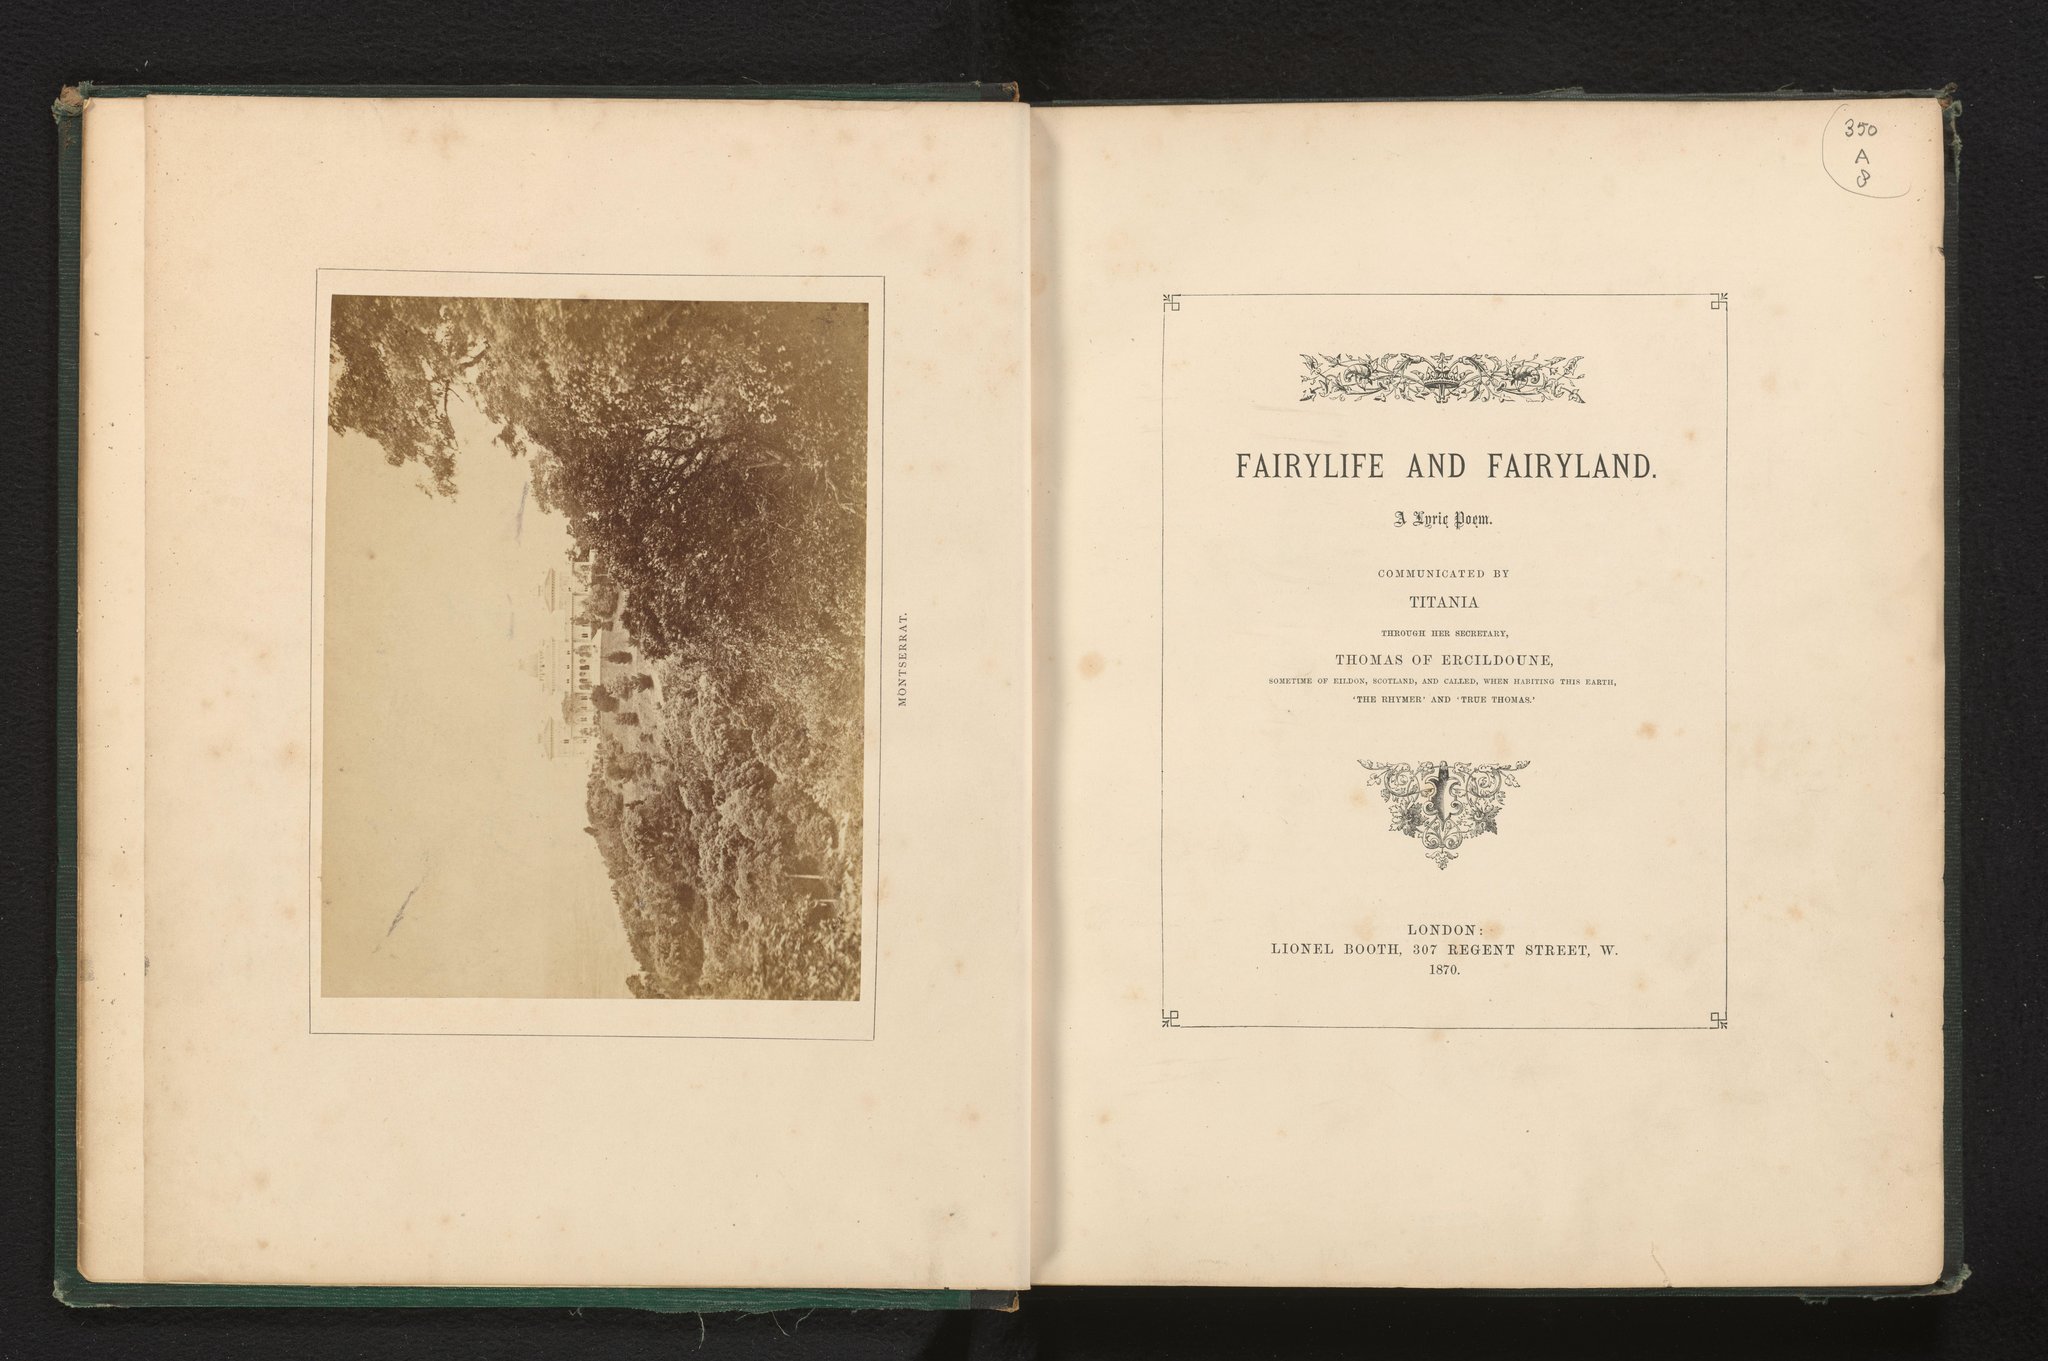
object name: book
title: Fairylife and fairyland a lyric poem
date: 1870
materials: cardboard, leather, linen, paper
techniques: albumen print, letterpress printing, printing block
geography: london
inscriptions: inscription: ‘Fairy Life/ n 1/2’, inscription: ‘(ONLY TWENTY-FIVE COPIES PRINTED.)/ NO. 5’